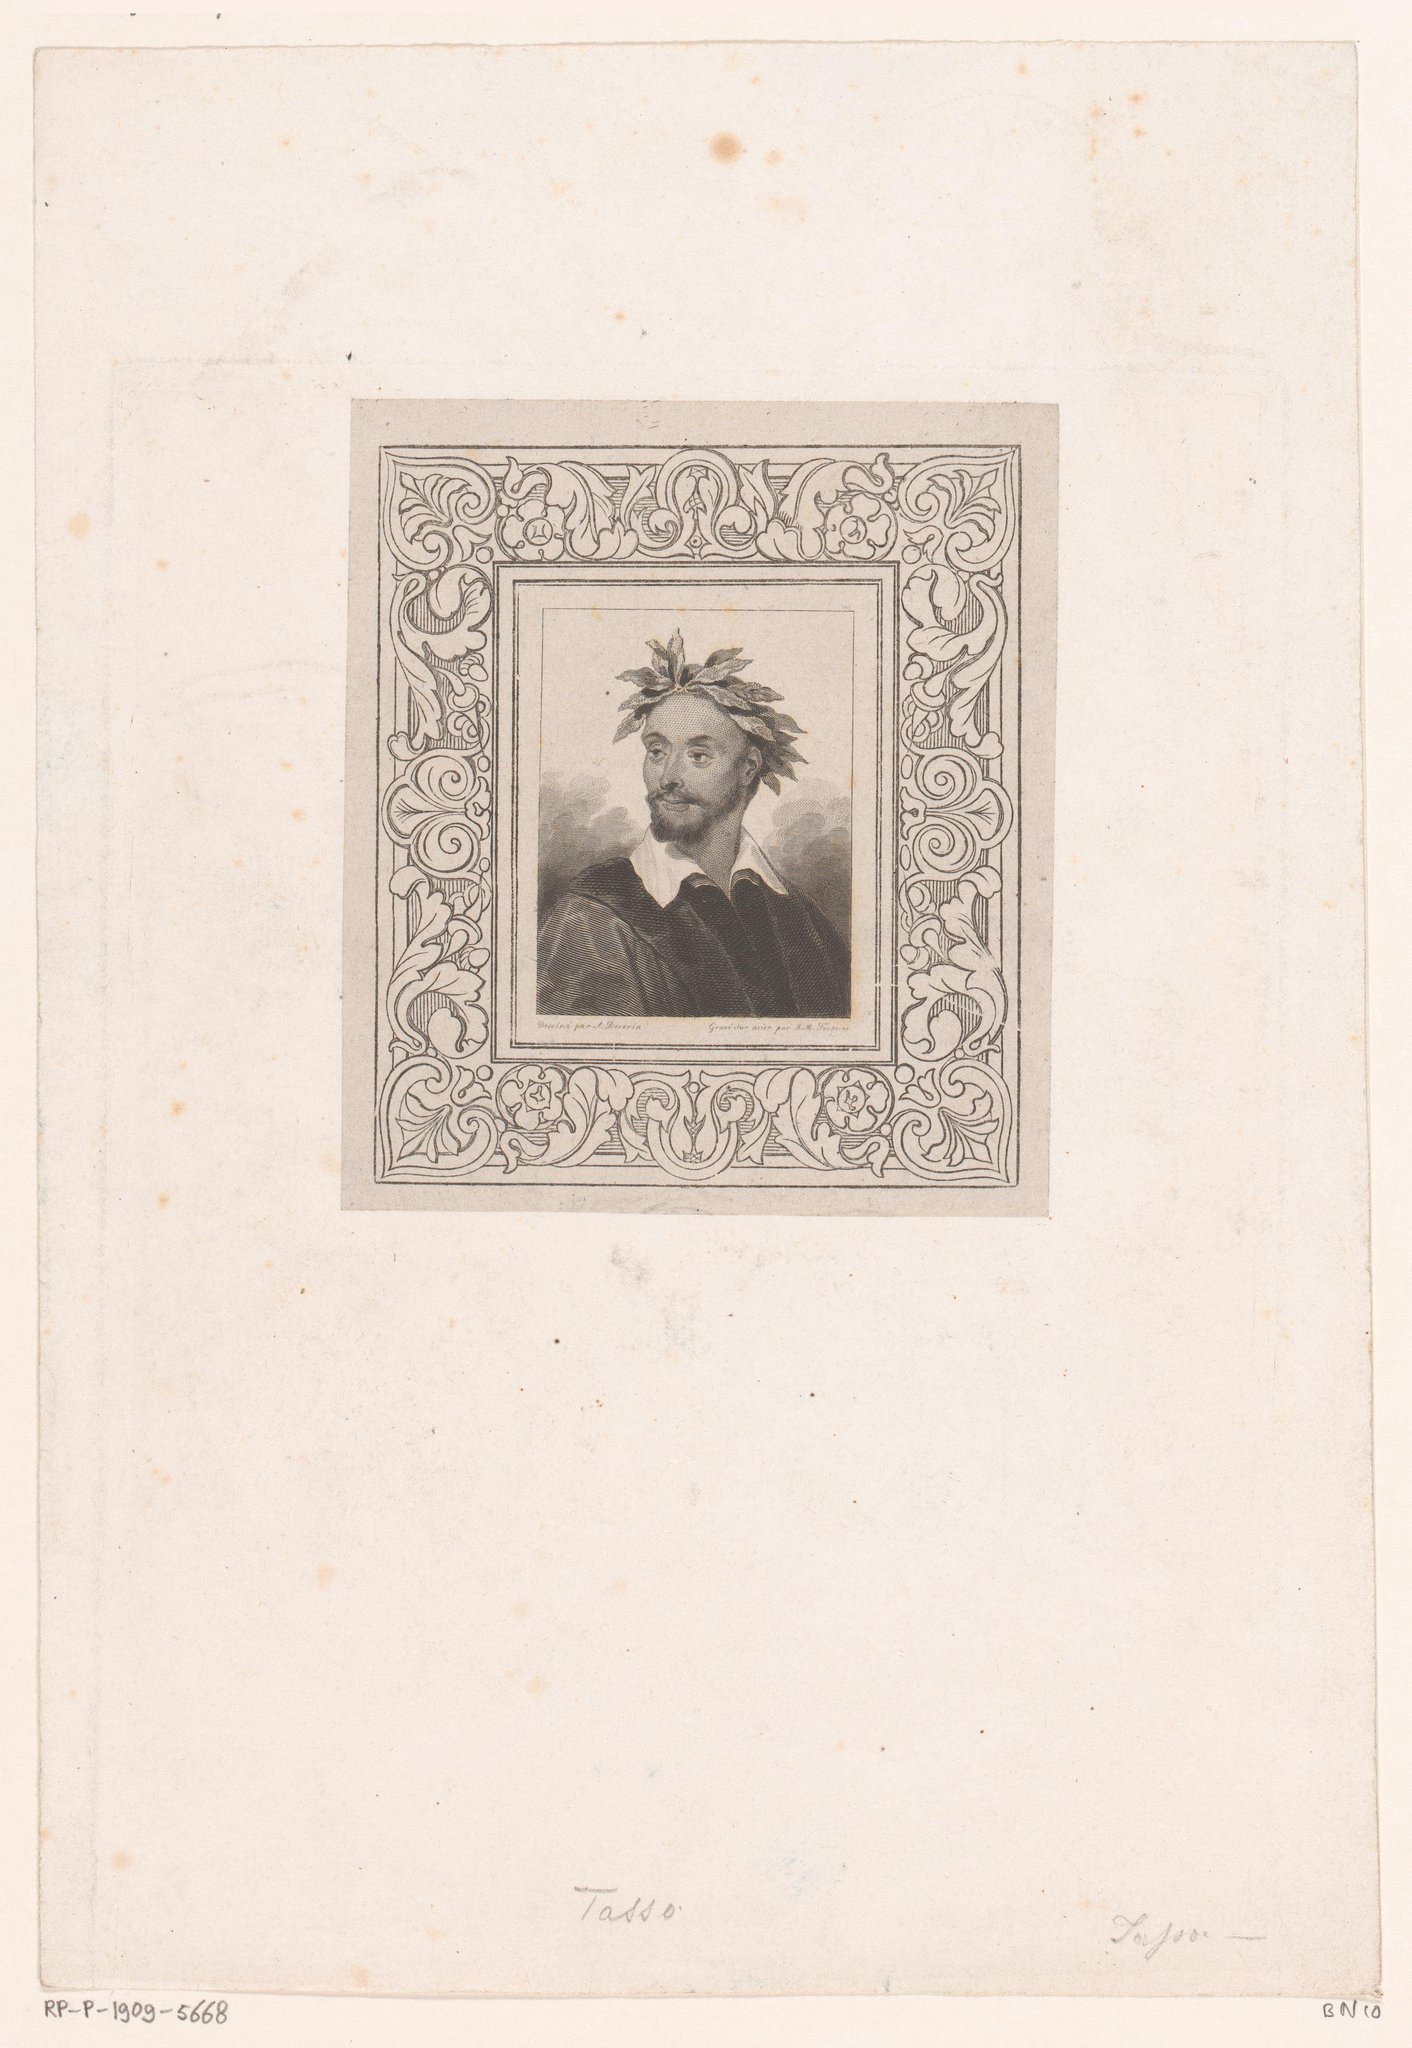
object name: book illustration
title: Portret van Torquato Tasso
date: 1827-1829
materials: paper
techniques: engraving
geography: france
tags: torquato tasso, historical persons, portrait of a writer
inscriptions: collector's mark: Lugt 2228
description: Volgens de literatuur betreft deze of een andere staat een prent uit: Jarry de Mancy, Adrien. Iconographie instructive, ou Collection de portraits des personnages les plus célèbres de l'histoire moderne, accompagnés et entourés d'une notice biographique, chronologique et bibliographique (...). Parijs: s.n., 1827.